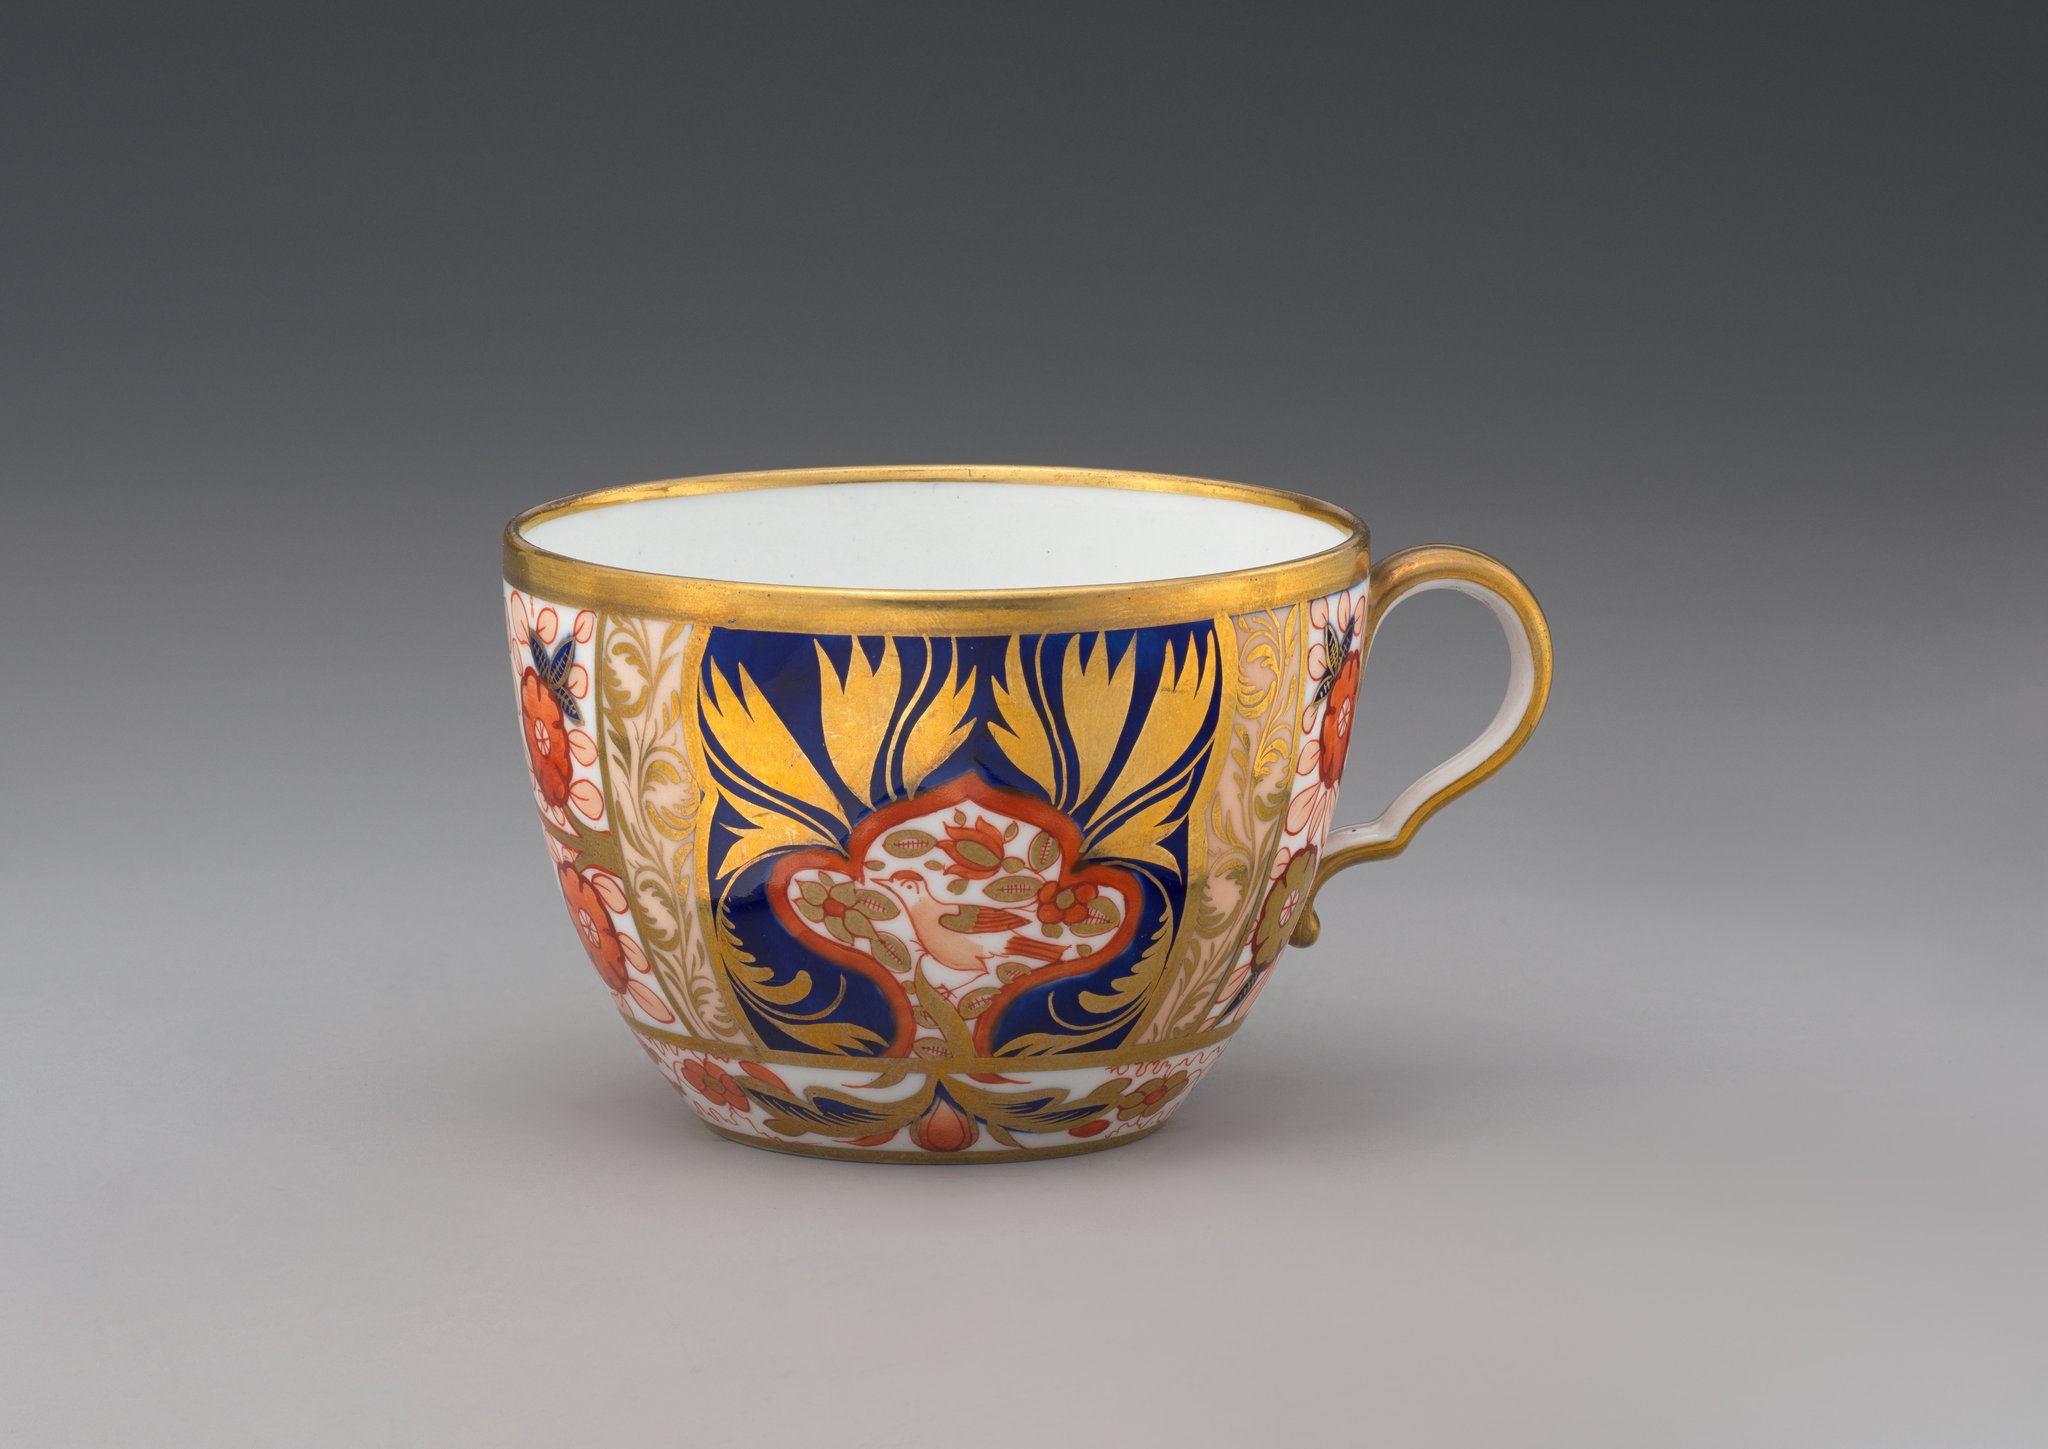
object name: cup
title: Cup (part of a service)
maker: j. spode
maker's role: factory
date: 1800-1830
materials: soft paste porcelain